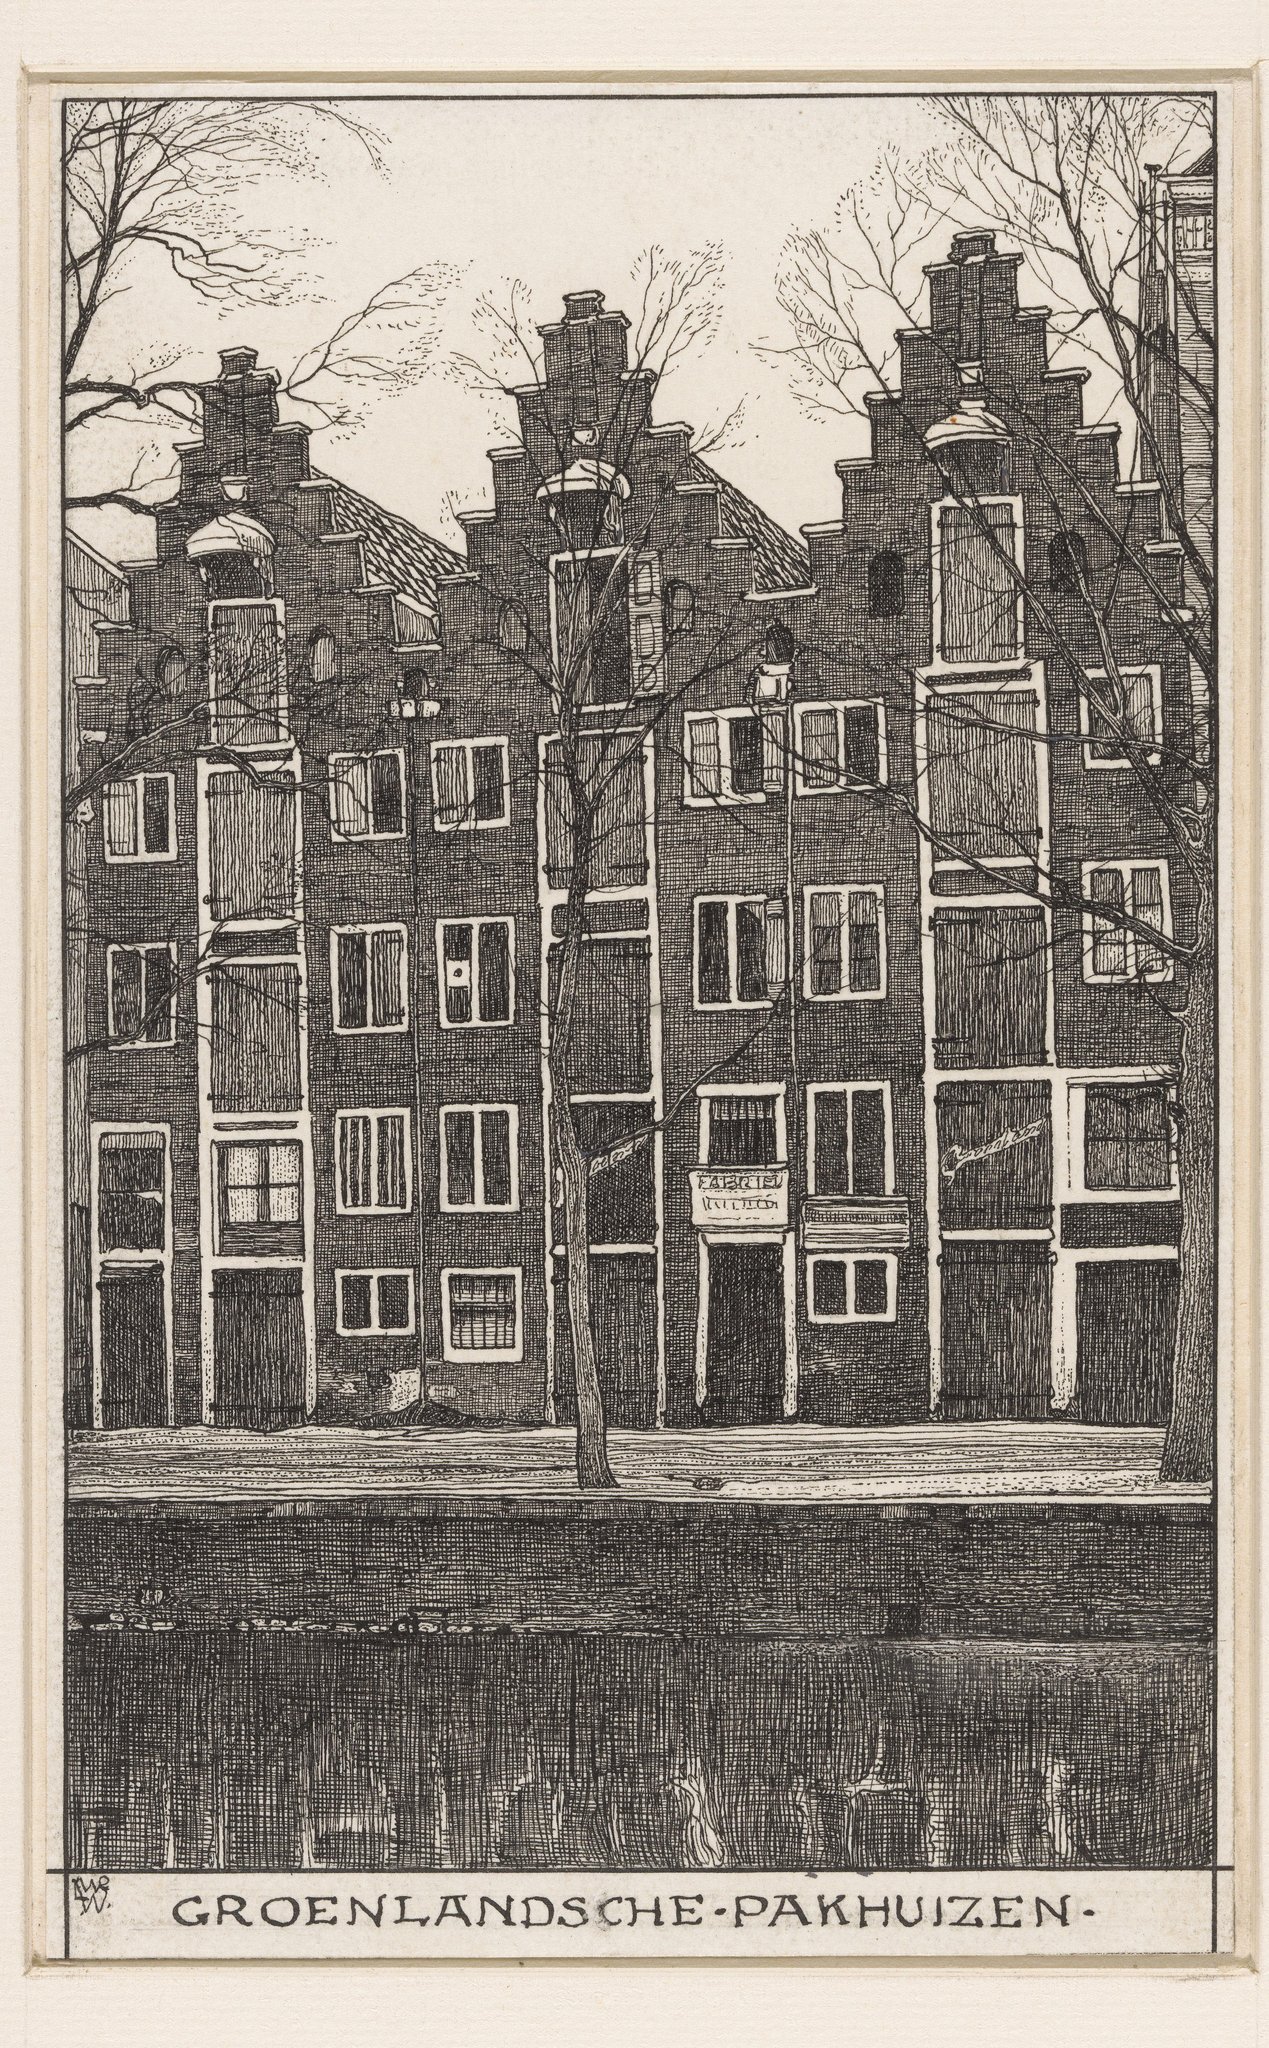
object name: drawing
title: Groenlandsche Pakhuizen te Amsterdam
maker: willem wenckebach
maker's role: designer, draughtsman, painter, print maker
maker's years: 1860-1937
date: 1870-1926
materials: paint, ink, paper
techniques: pen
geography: amsterdam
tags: street